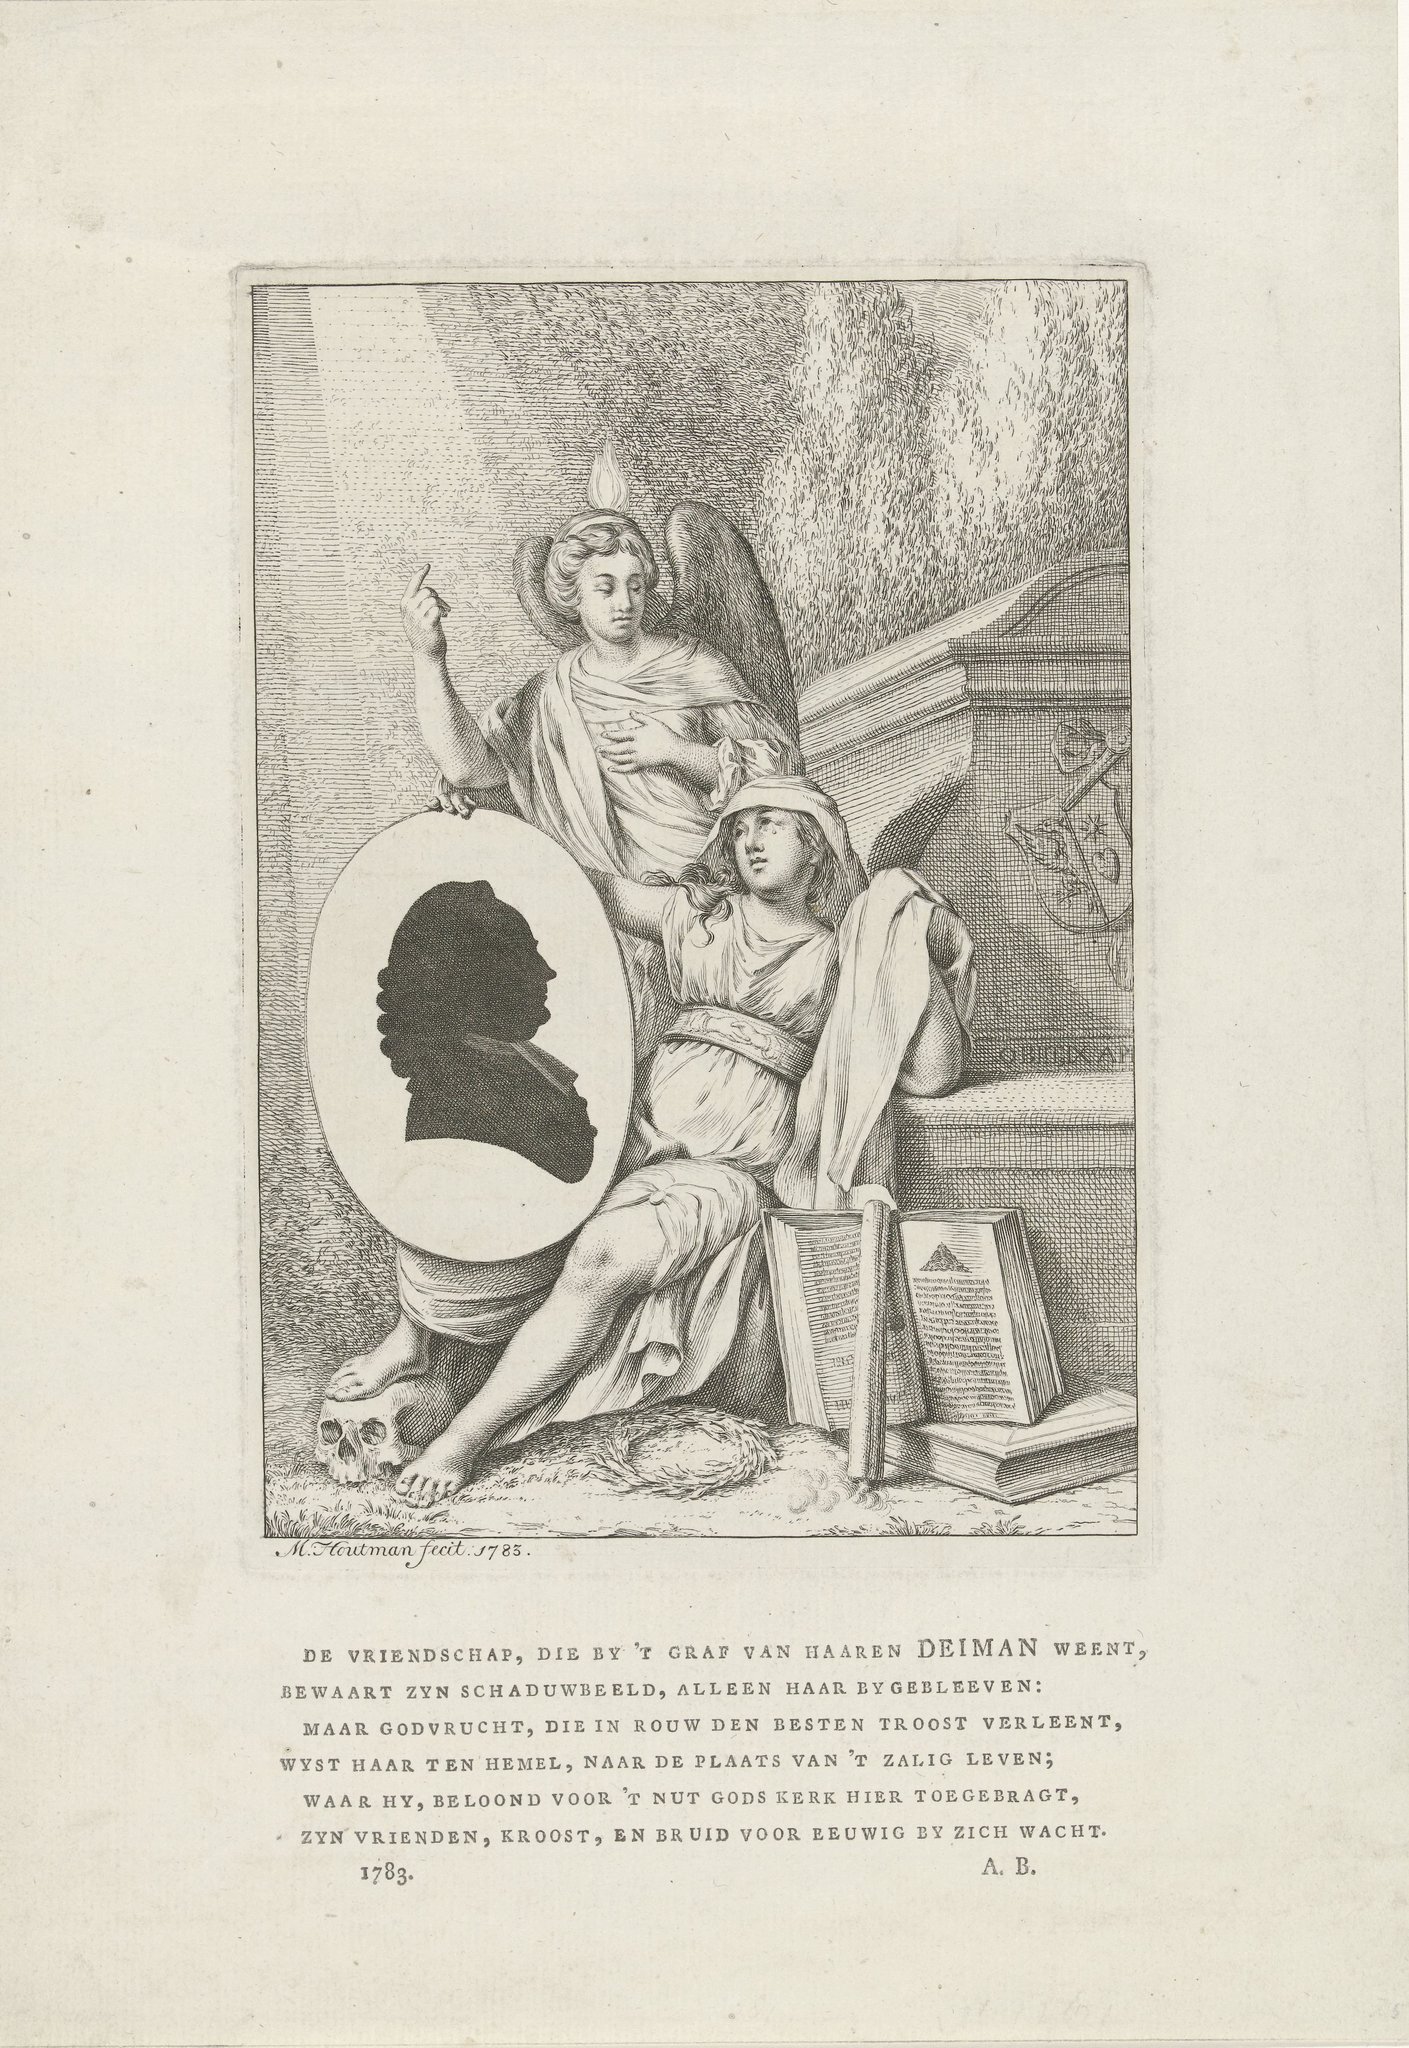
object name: print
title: Gedenkteken voor Johan Diederich Deiman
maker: monogrammist ab (18e eeuw ; schrijver)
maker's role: schrijver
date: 1783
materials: paper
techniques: engraving, etching, letterpress printing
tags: utrecht, other memorial structures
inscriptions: collector's mark: Lugt 2760, collector's mark: Lugt 2228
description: Twee allegorische figuren bij een grafmonument. De godsvrucht wordt gepersonifieerd door een engel met vlam op het hoofd, die wijst naar een lichtstraal. De vriendschap wordt verbeeld door een wenende vrouw met een schedel onder haar voet en een lauwerkrans en enkele boeken op de grond naast haar. Zij toont het silhouetportret van J.D. Deiman. Onder de voorstelling zes regels tekst in het Nederlands.